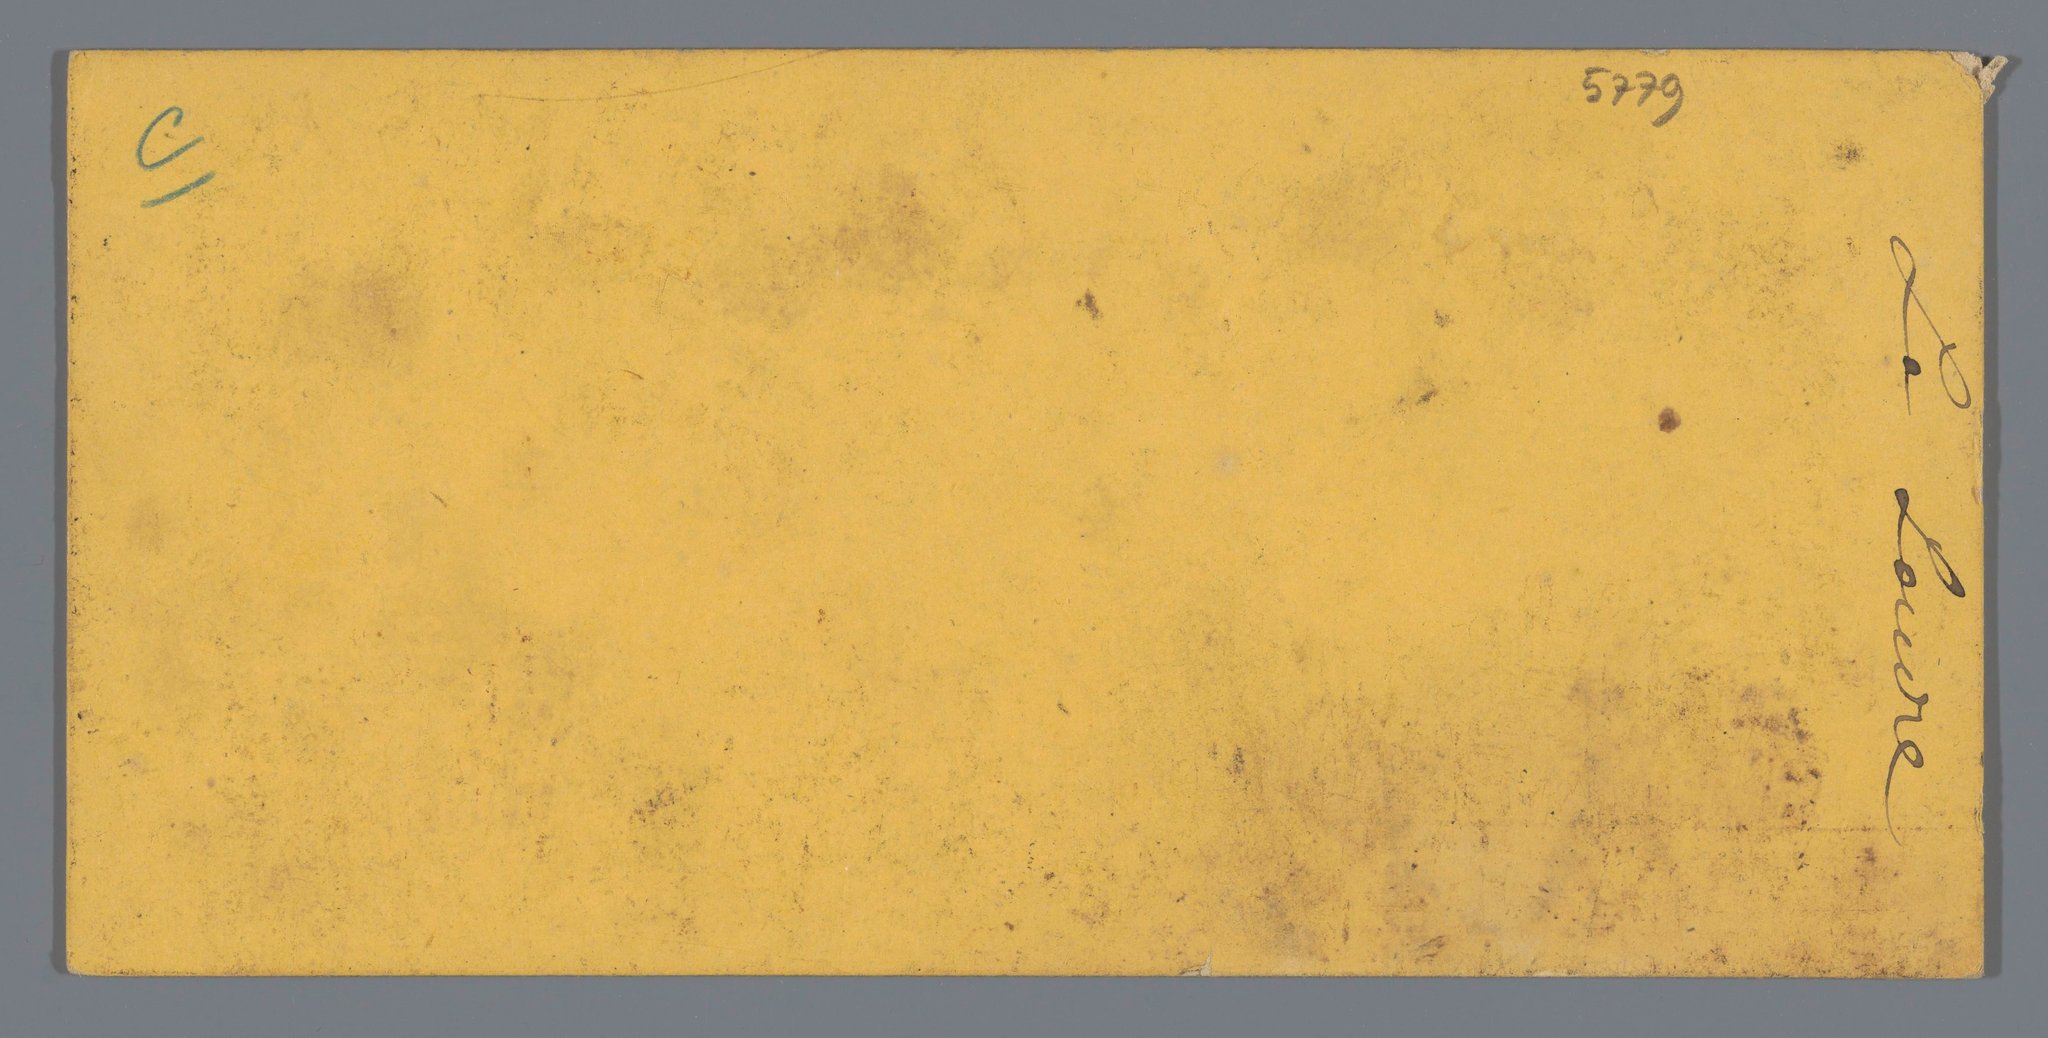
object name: stereograph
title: Gezicht op het Musée du Louvre in Parijs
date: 1850-1880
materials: cardboard, photographic support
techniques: albumen print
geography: paris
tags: permanent exhibition, museum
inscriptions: inscription: ‘La Louvre’